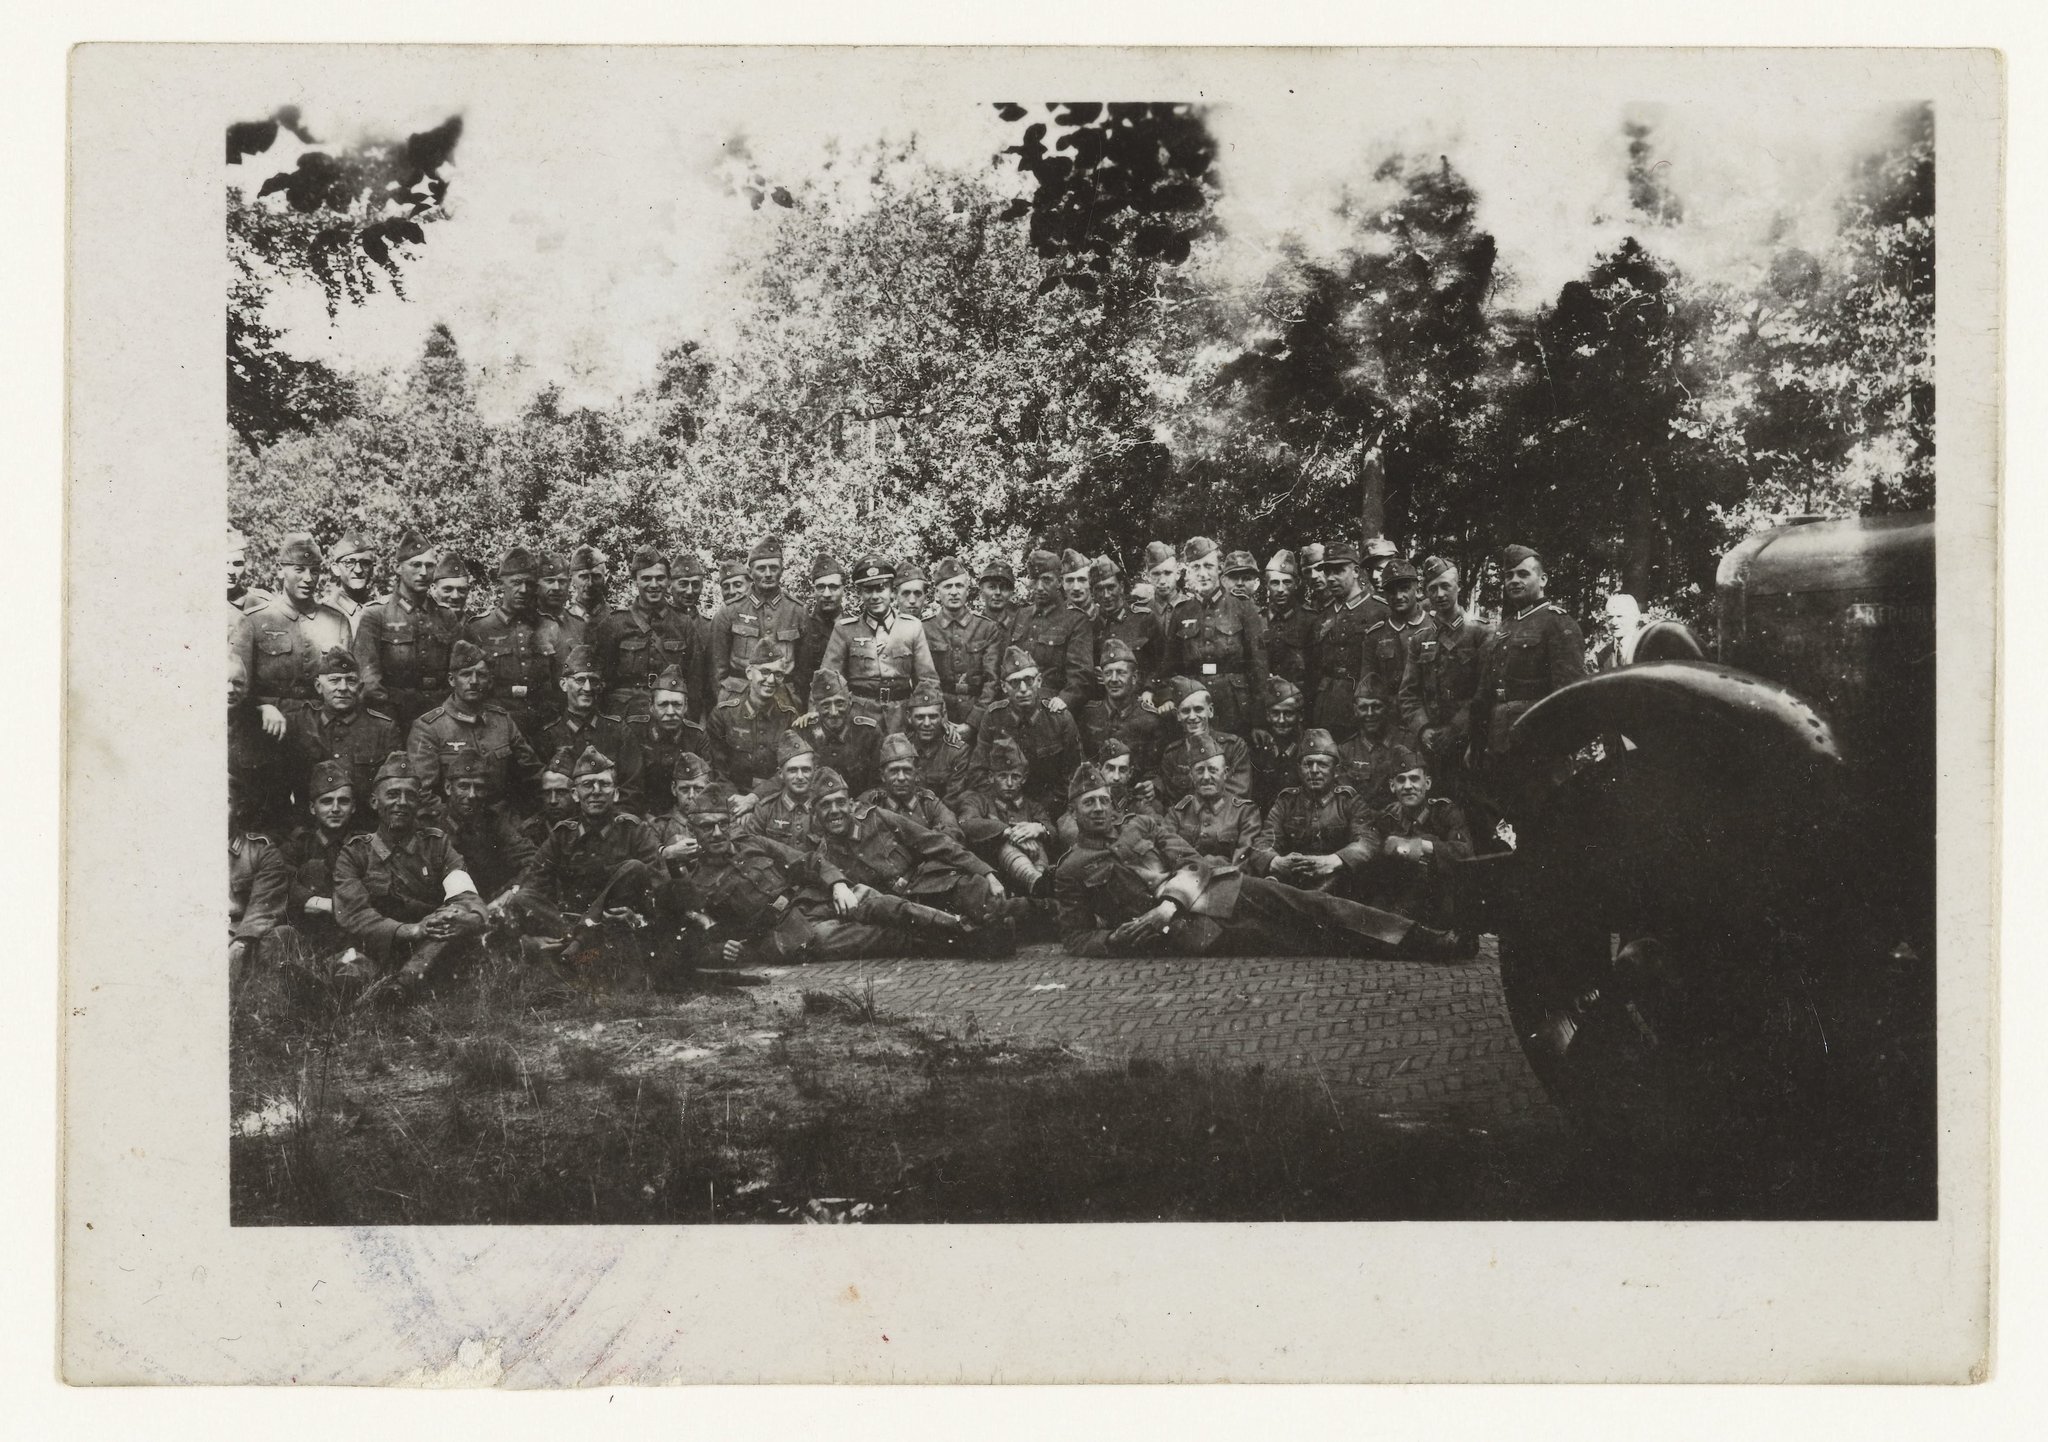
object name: photograph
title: Duitsers in uniform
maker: Anonymous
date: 1908-1943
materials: photographic support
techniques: gelatin silver print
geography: netherlands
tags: the company, the unit, the troop ~ military service, netherlands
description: Leden van de Wehrmacht en mogelijk het NSKK, National Sozialistischer Kraftfahrer Korps, als groep ergens buiten gefotografeerd. Rechts op de voorgrond de neus van een vrachtwagen. De Nederlandse afdeling van de NSKK werd in 1941 opgericht.